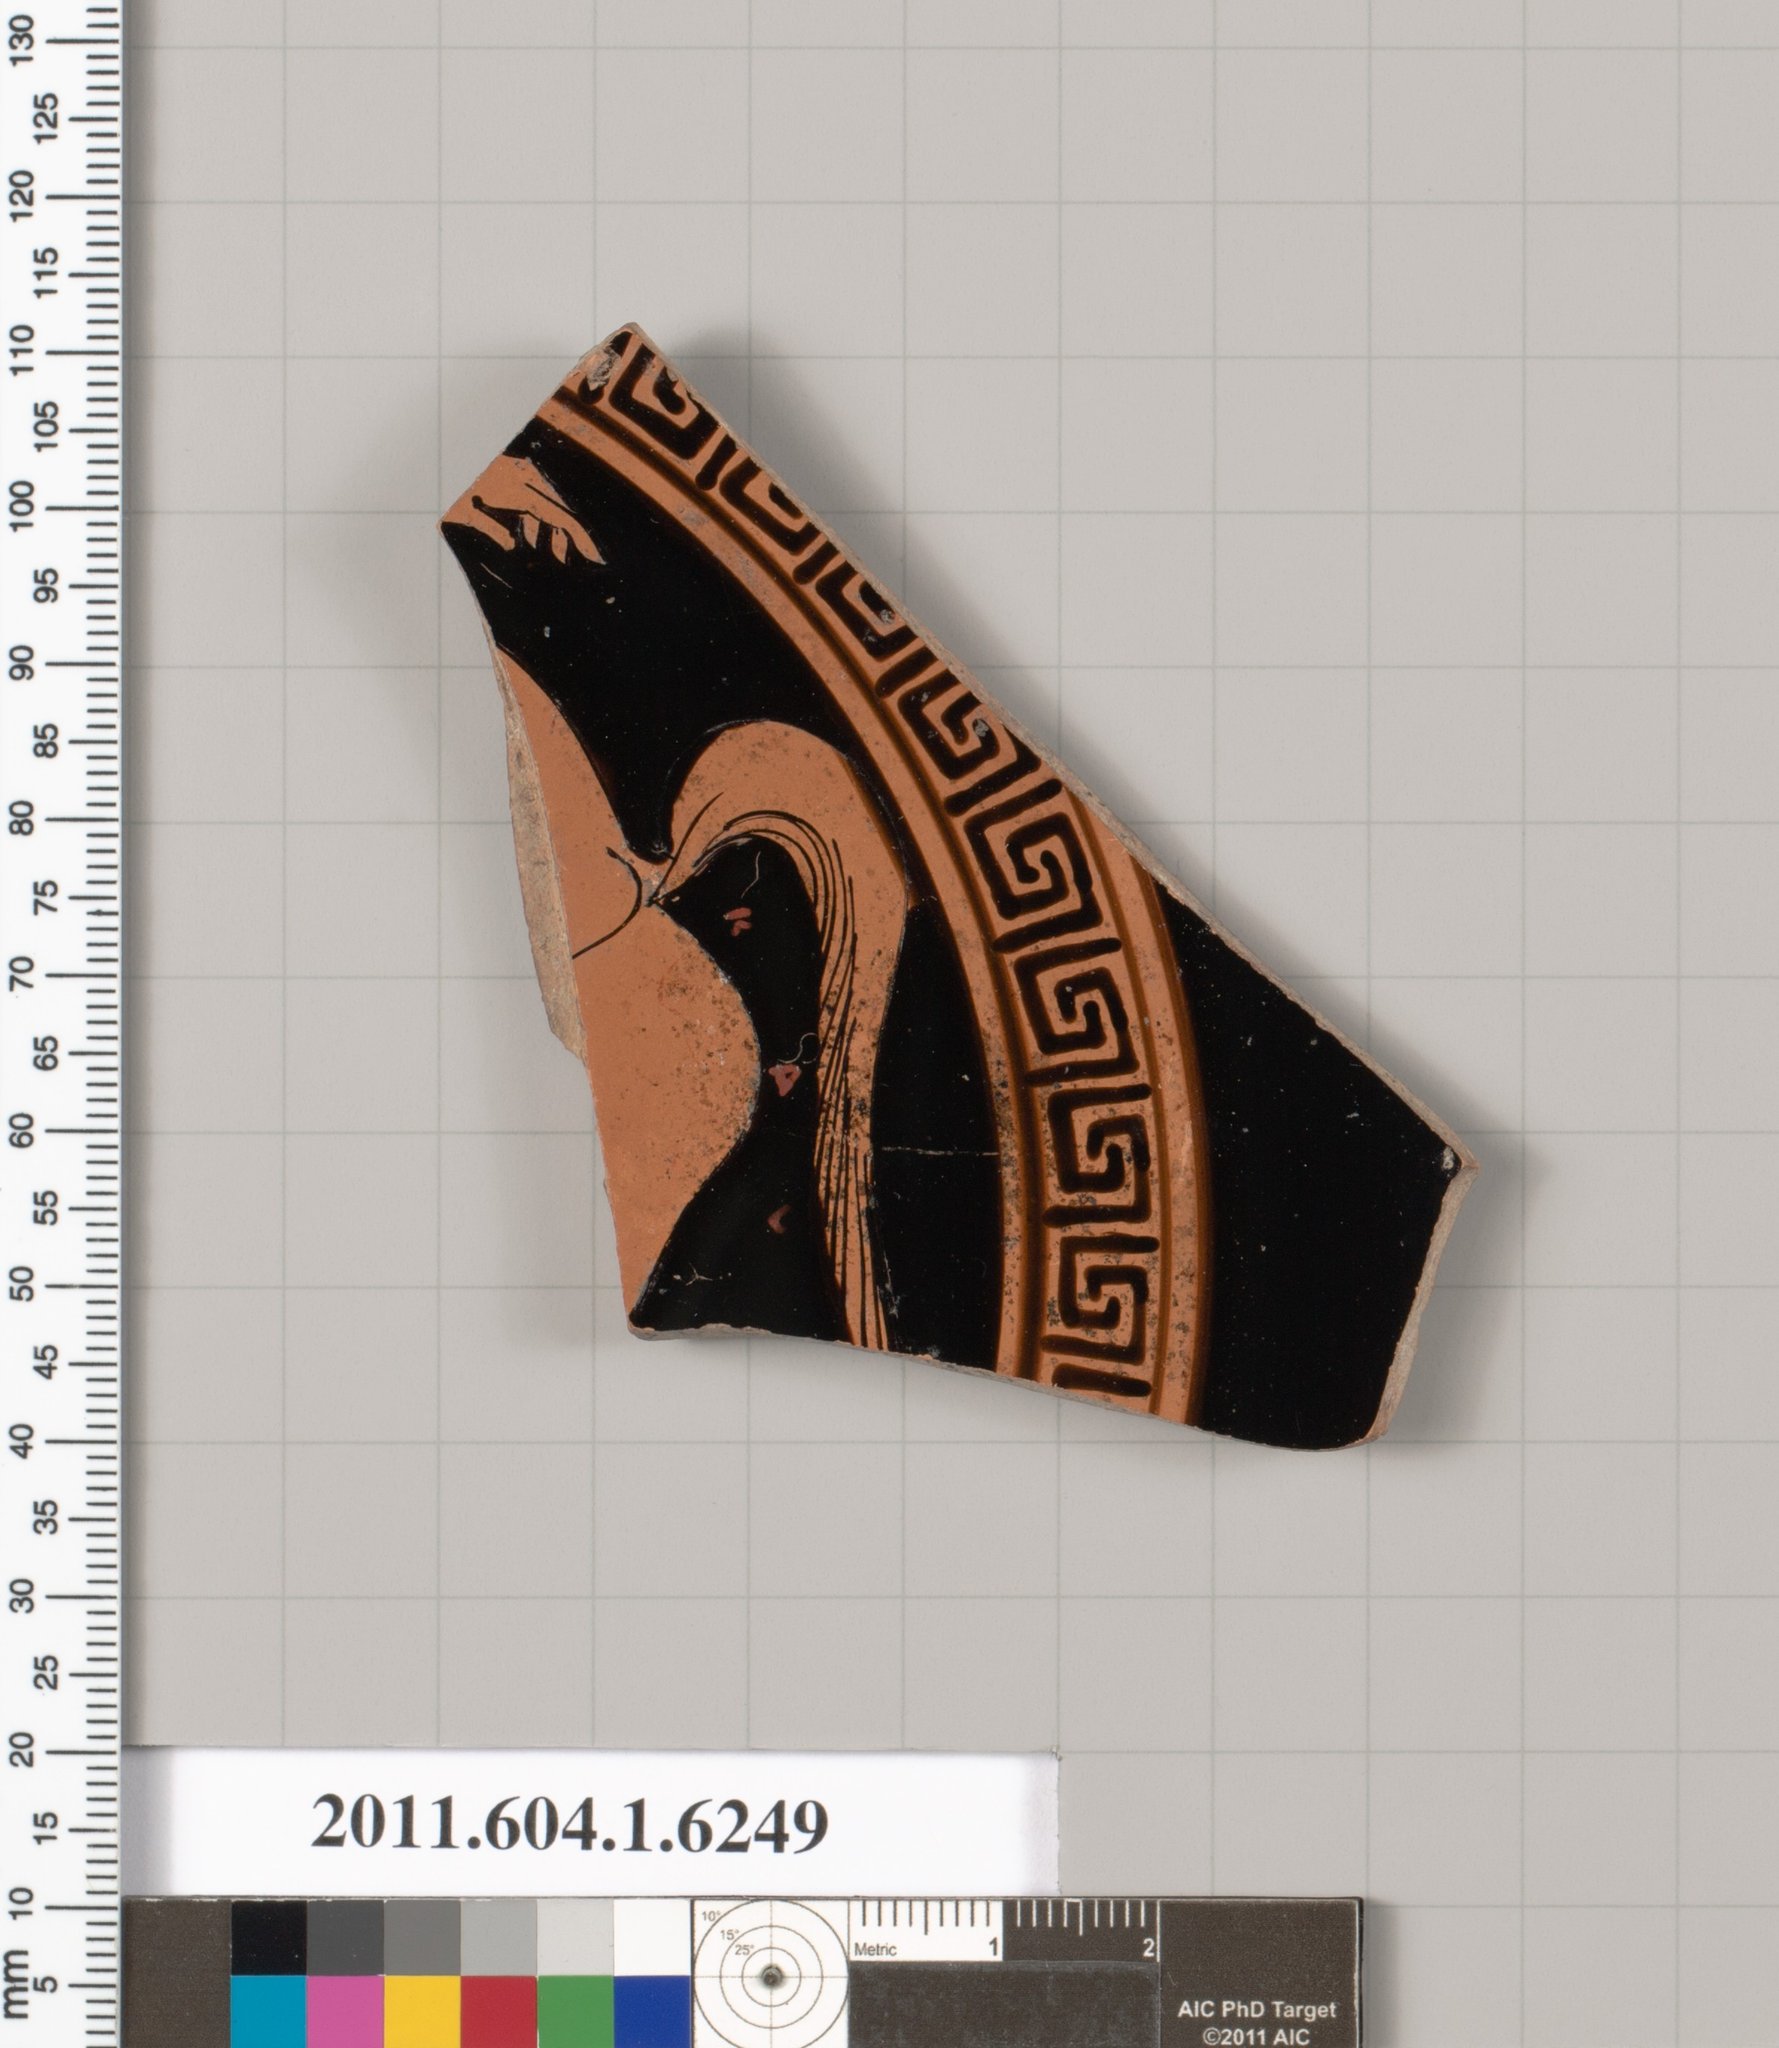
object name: kylix fragment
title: Terracotta fragment of a kylix (drinking cup)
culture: greek, attic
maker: onesimos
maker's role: artist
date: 500-480 BCE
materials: terracotta